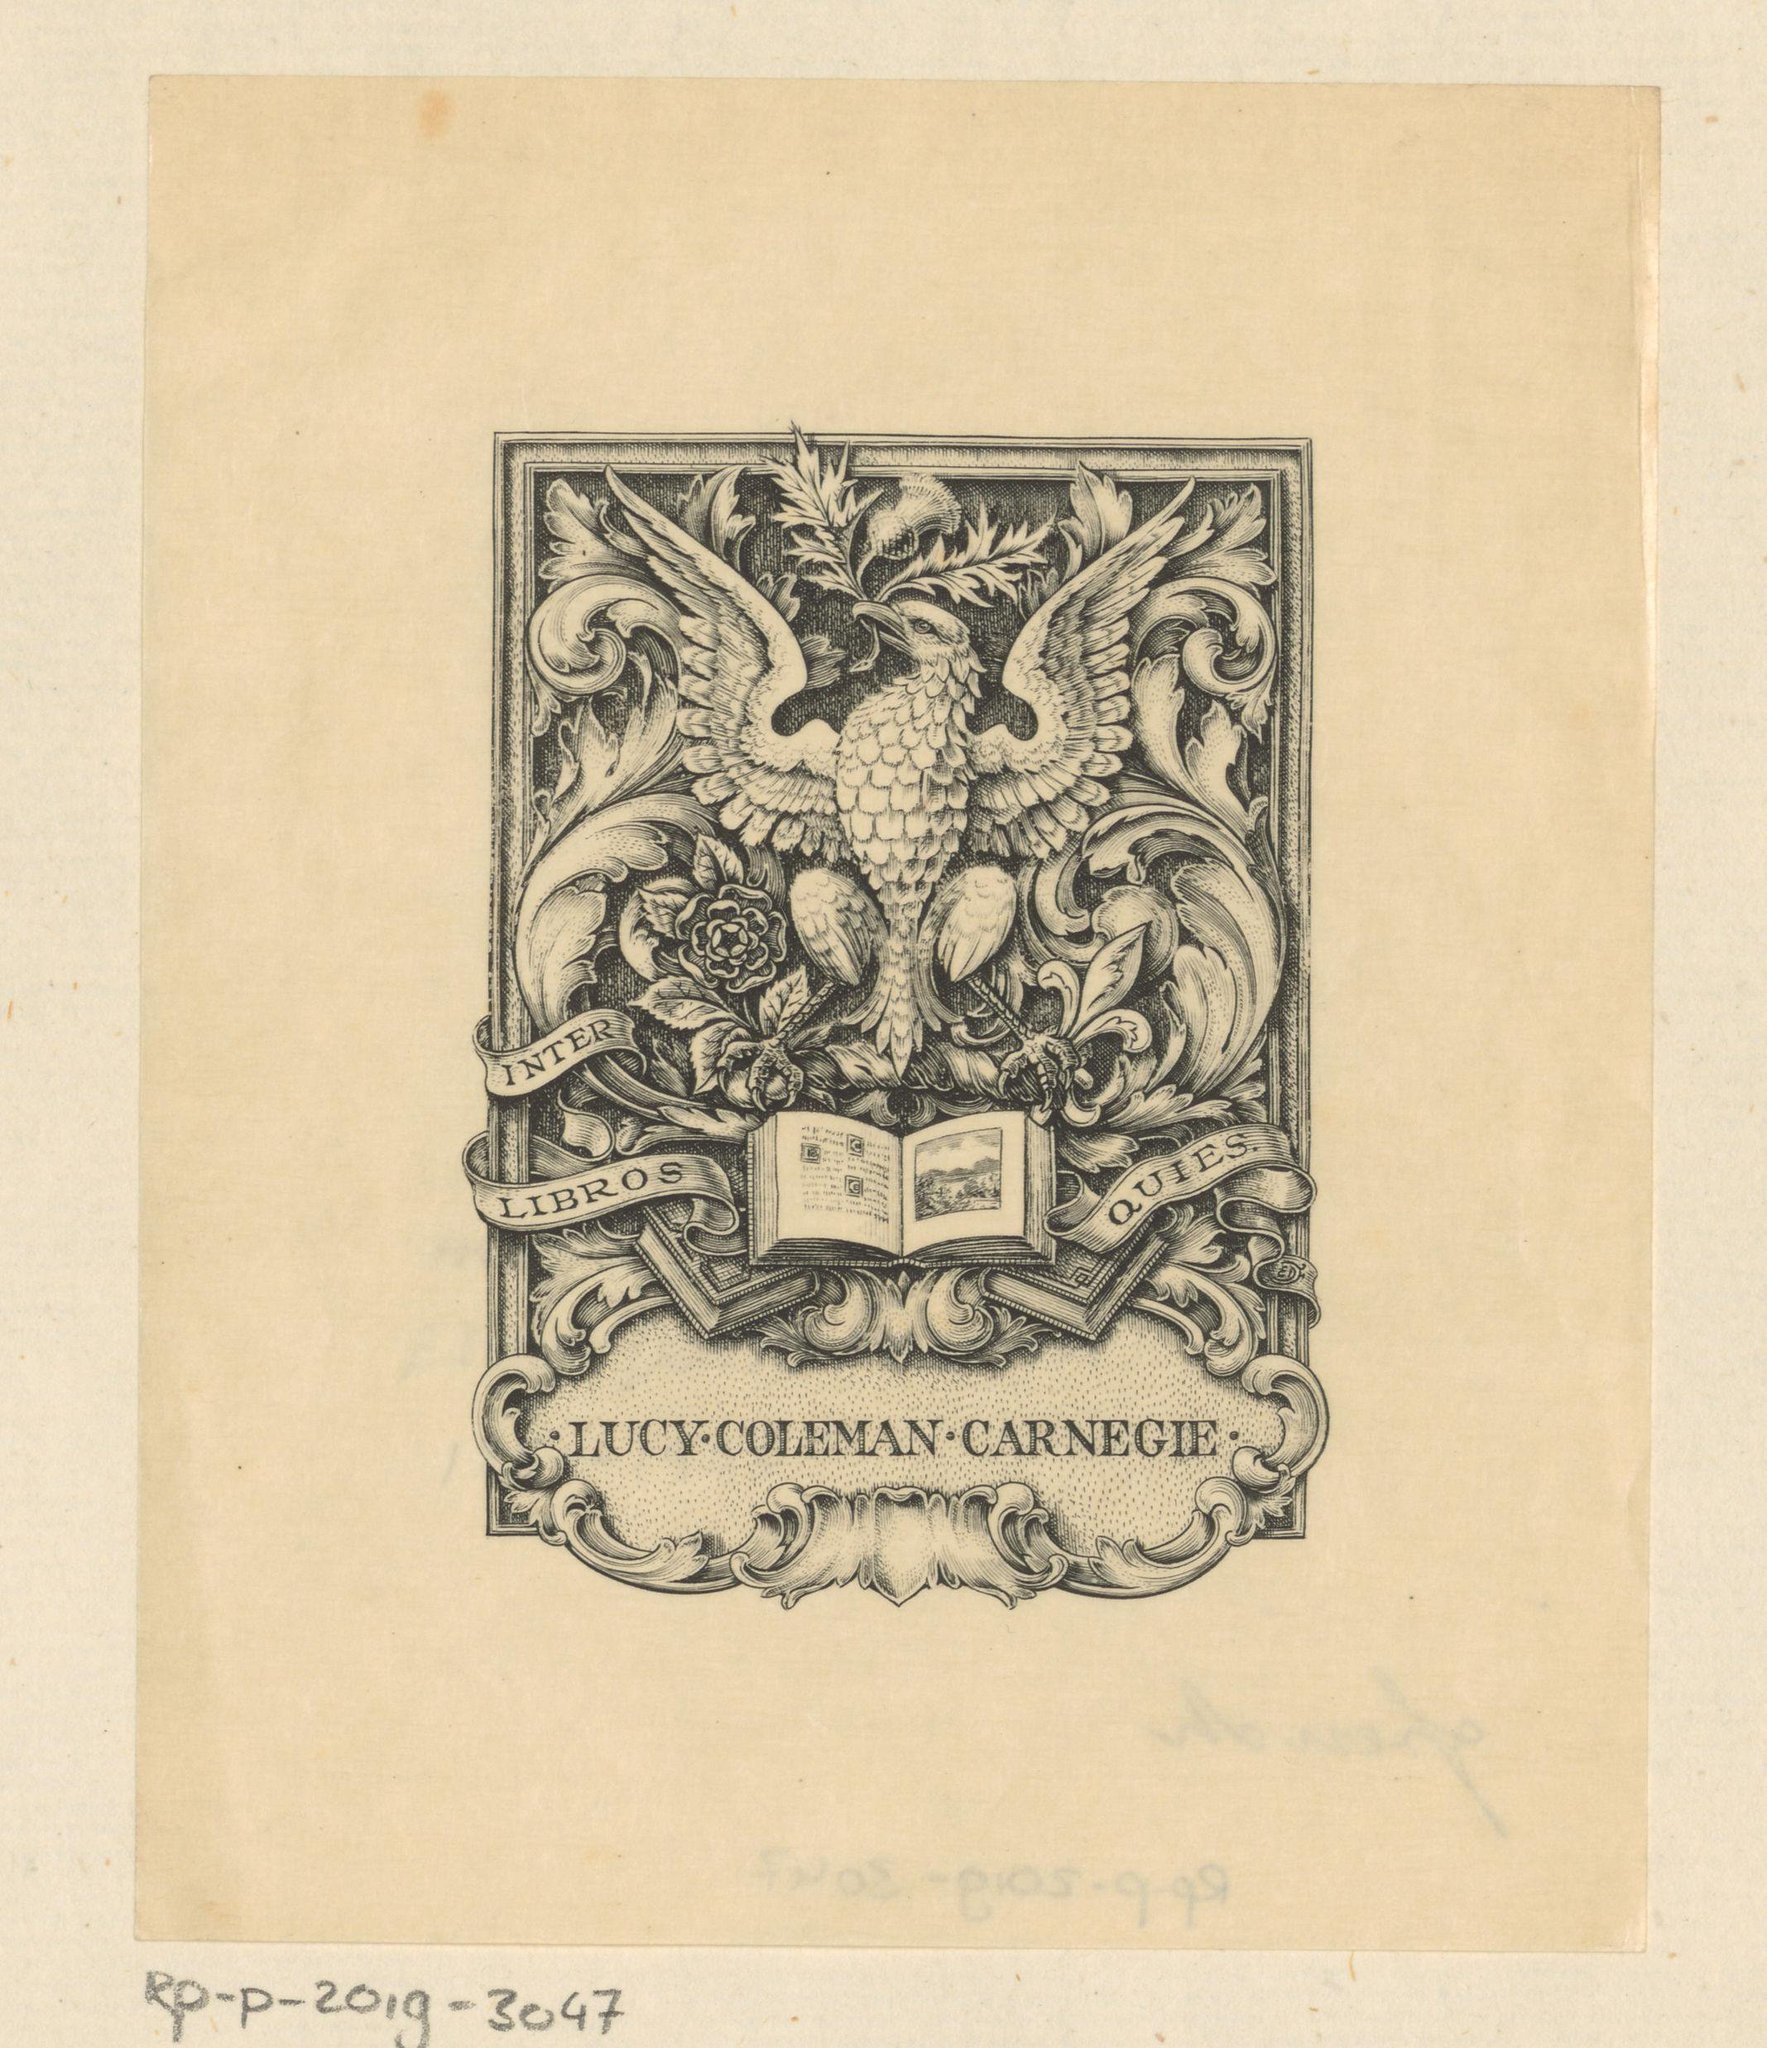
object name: bookplate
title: Ex libris van Lucy Coleman Carnegie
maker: edwin davis french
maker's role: print maker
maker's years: 1851-1906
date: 1861-1906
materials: paper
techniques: engraving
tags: book, predatory birds, plants and herbs: thistle